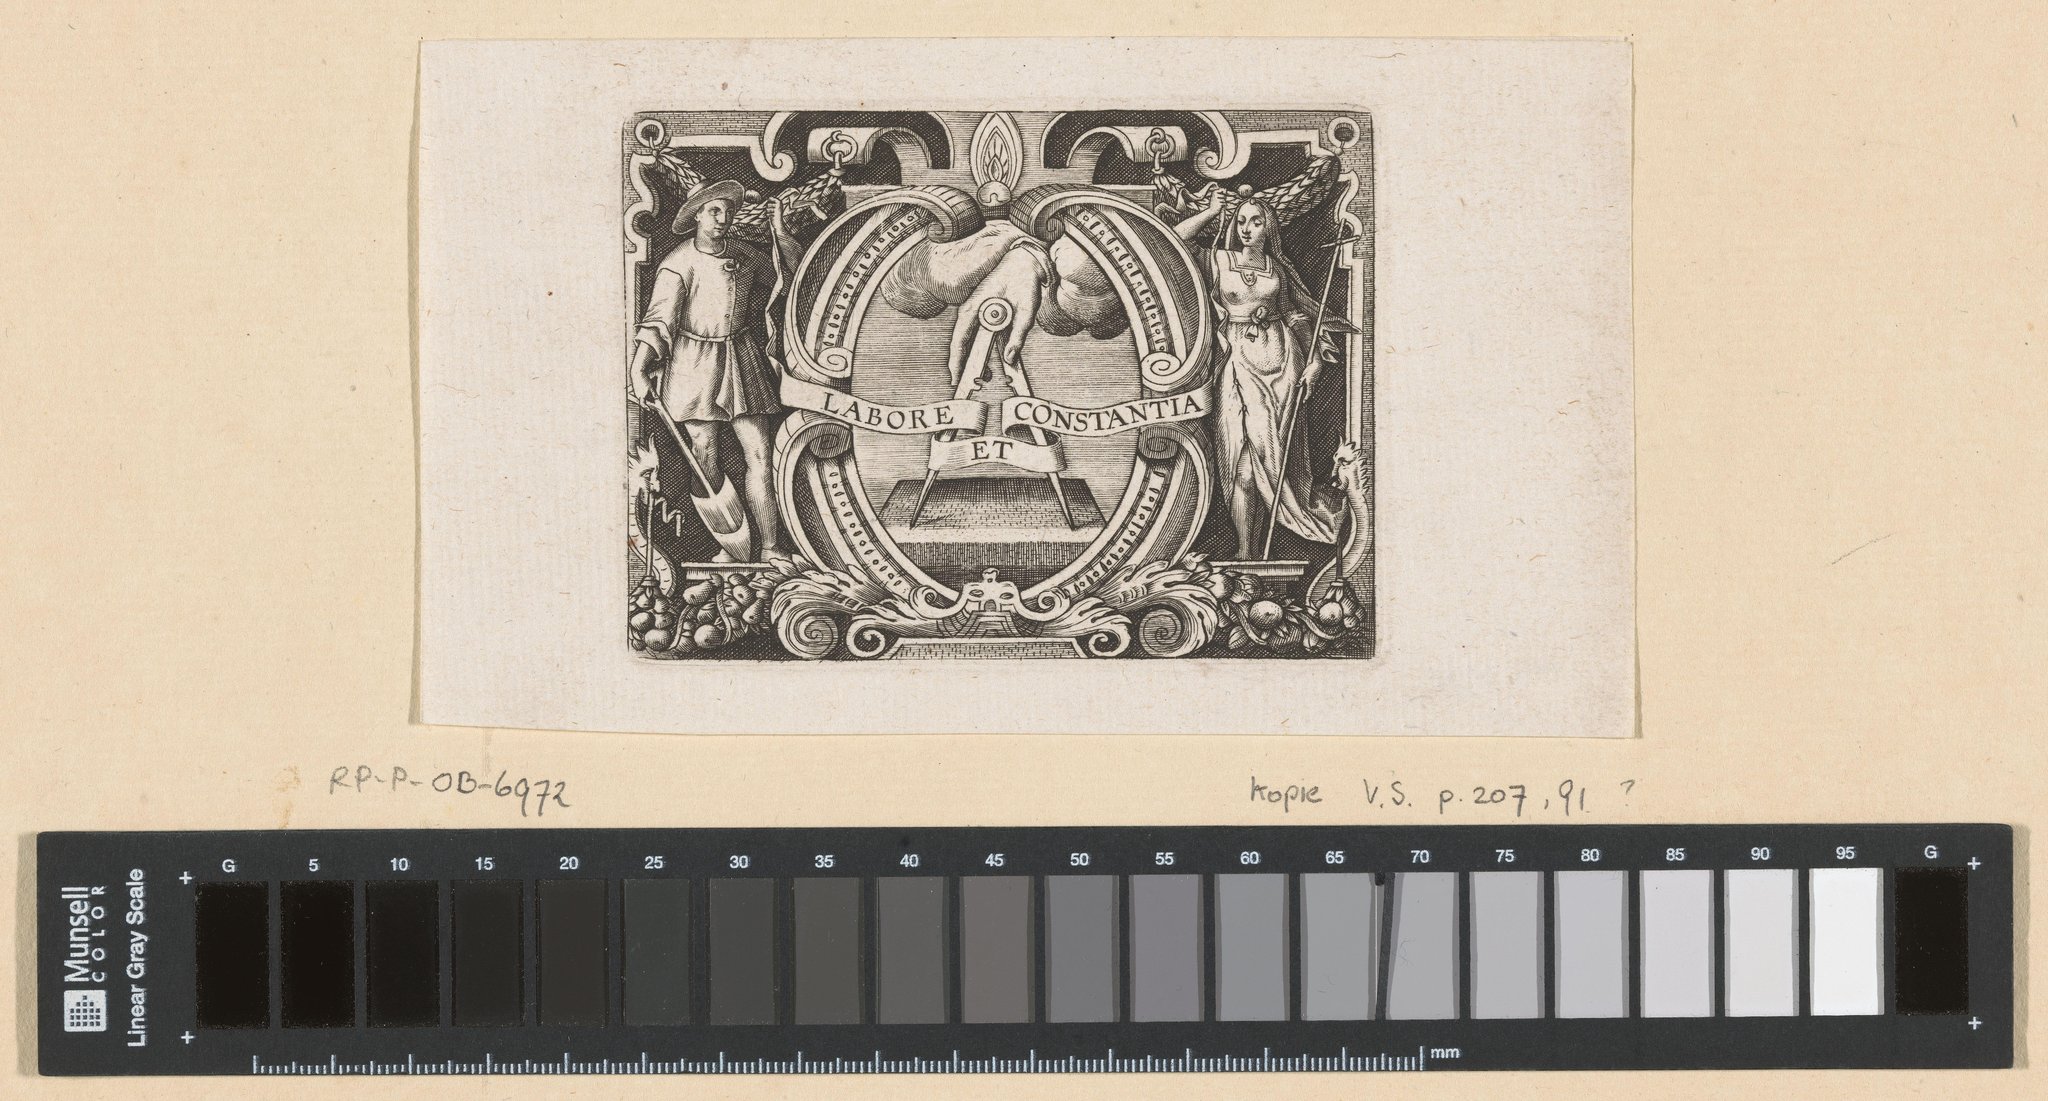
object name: print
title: Drukkersmerk voor de officina Plantiniana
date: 1600-1699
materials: paper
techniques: engraving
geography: antwerp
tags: compasses, device (trade-mark of printer or publisher)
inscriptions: collector's mark: Lugt 240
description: Drukkersmerk voor de drukkerij Plantijn-Moretus in Antwerpen. In het midden een hand met een passer, een verwijzing naar het uithangbord van de drukkerij "De gulden passer". Op een spreukband het motto van Christoffel Plantijn: Labore et constantia.